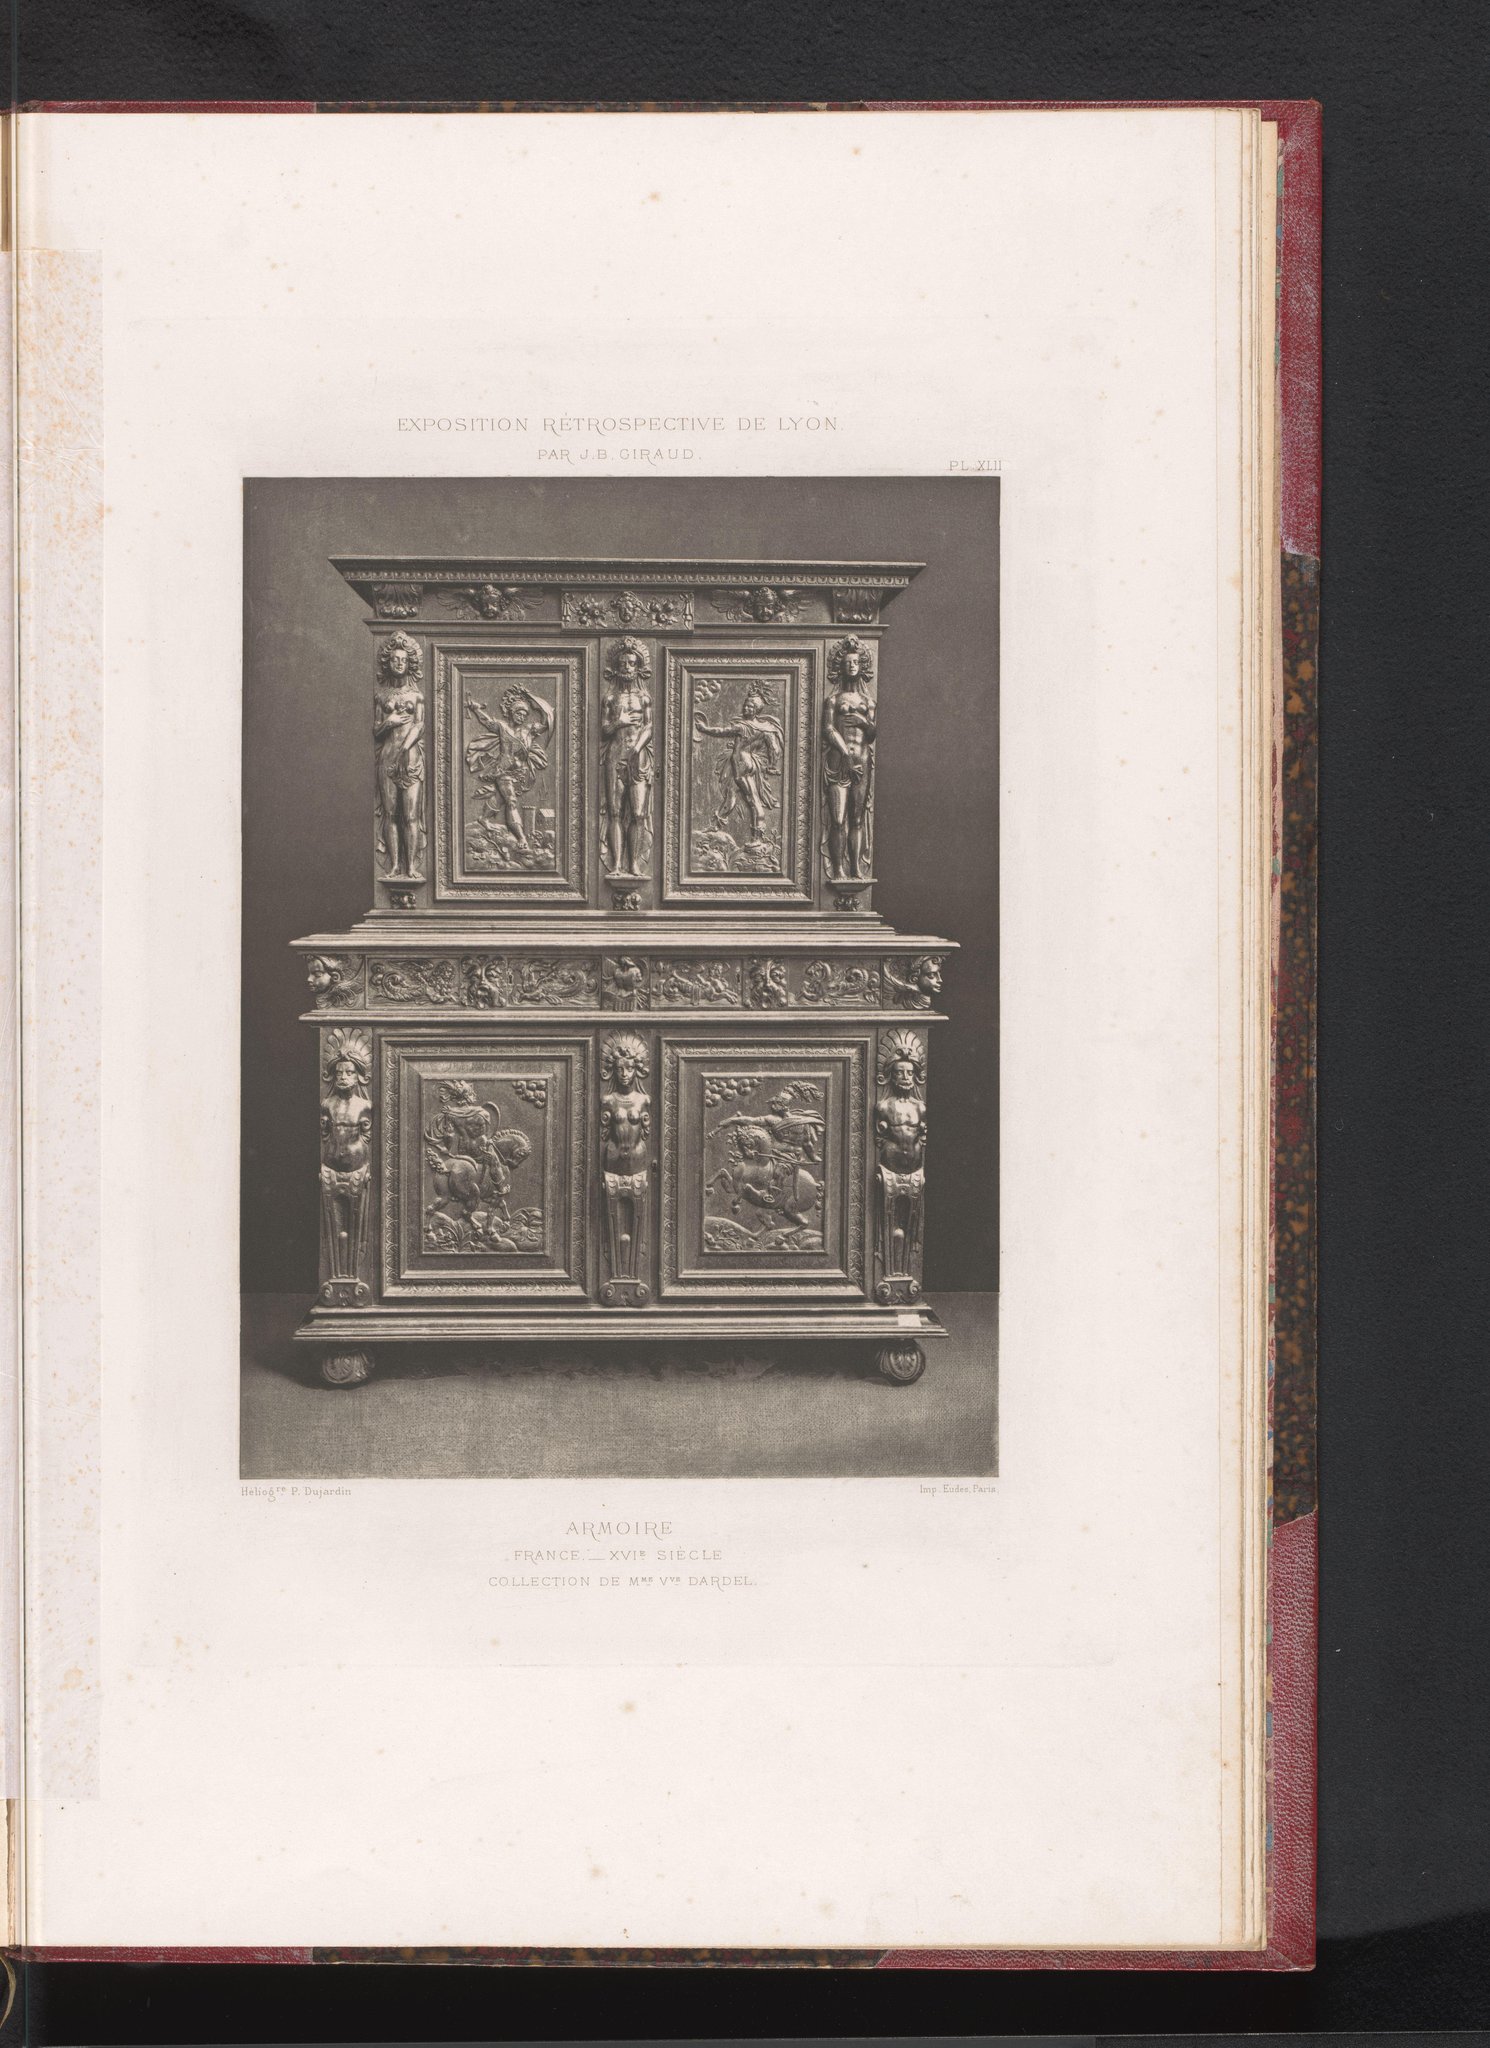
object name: page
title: 16de-eeuwse Franse kast van hout, op de Exposition Rétrospective van 1877 in Lyon, Frankrijk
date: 1877-1880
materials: paper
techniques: photoaquatint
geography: paris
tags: ornamental cupboard (+ wood and other phytogenic material), lyon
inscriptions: inscription: ‘ARMOIRE/ FRANCE_XVIe SIÈCLE/ COLLECTION DE Mme Vve DARDEL.’, inscription: ‘EXPOSITION RÉTROSPECTIVE DE LYON/ PAR J. B. GIRAUD.’, number: ‘PL. XLII.’